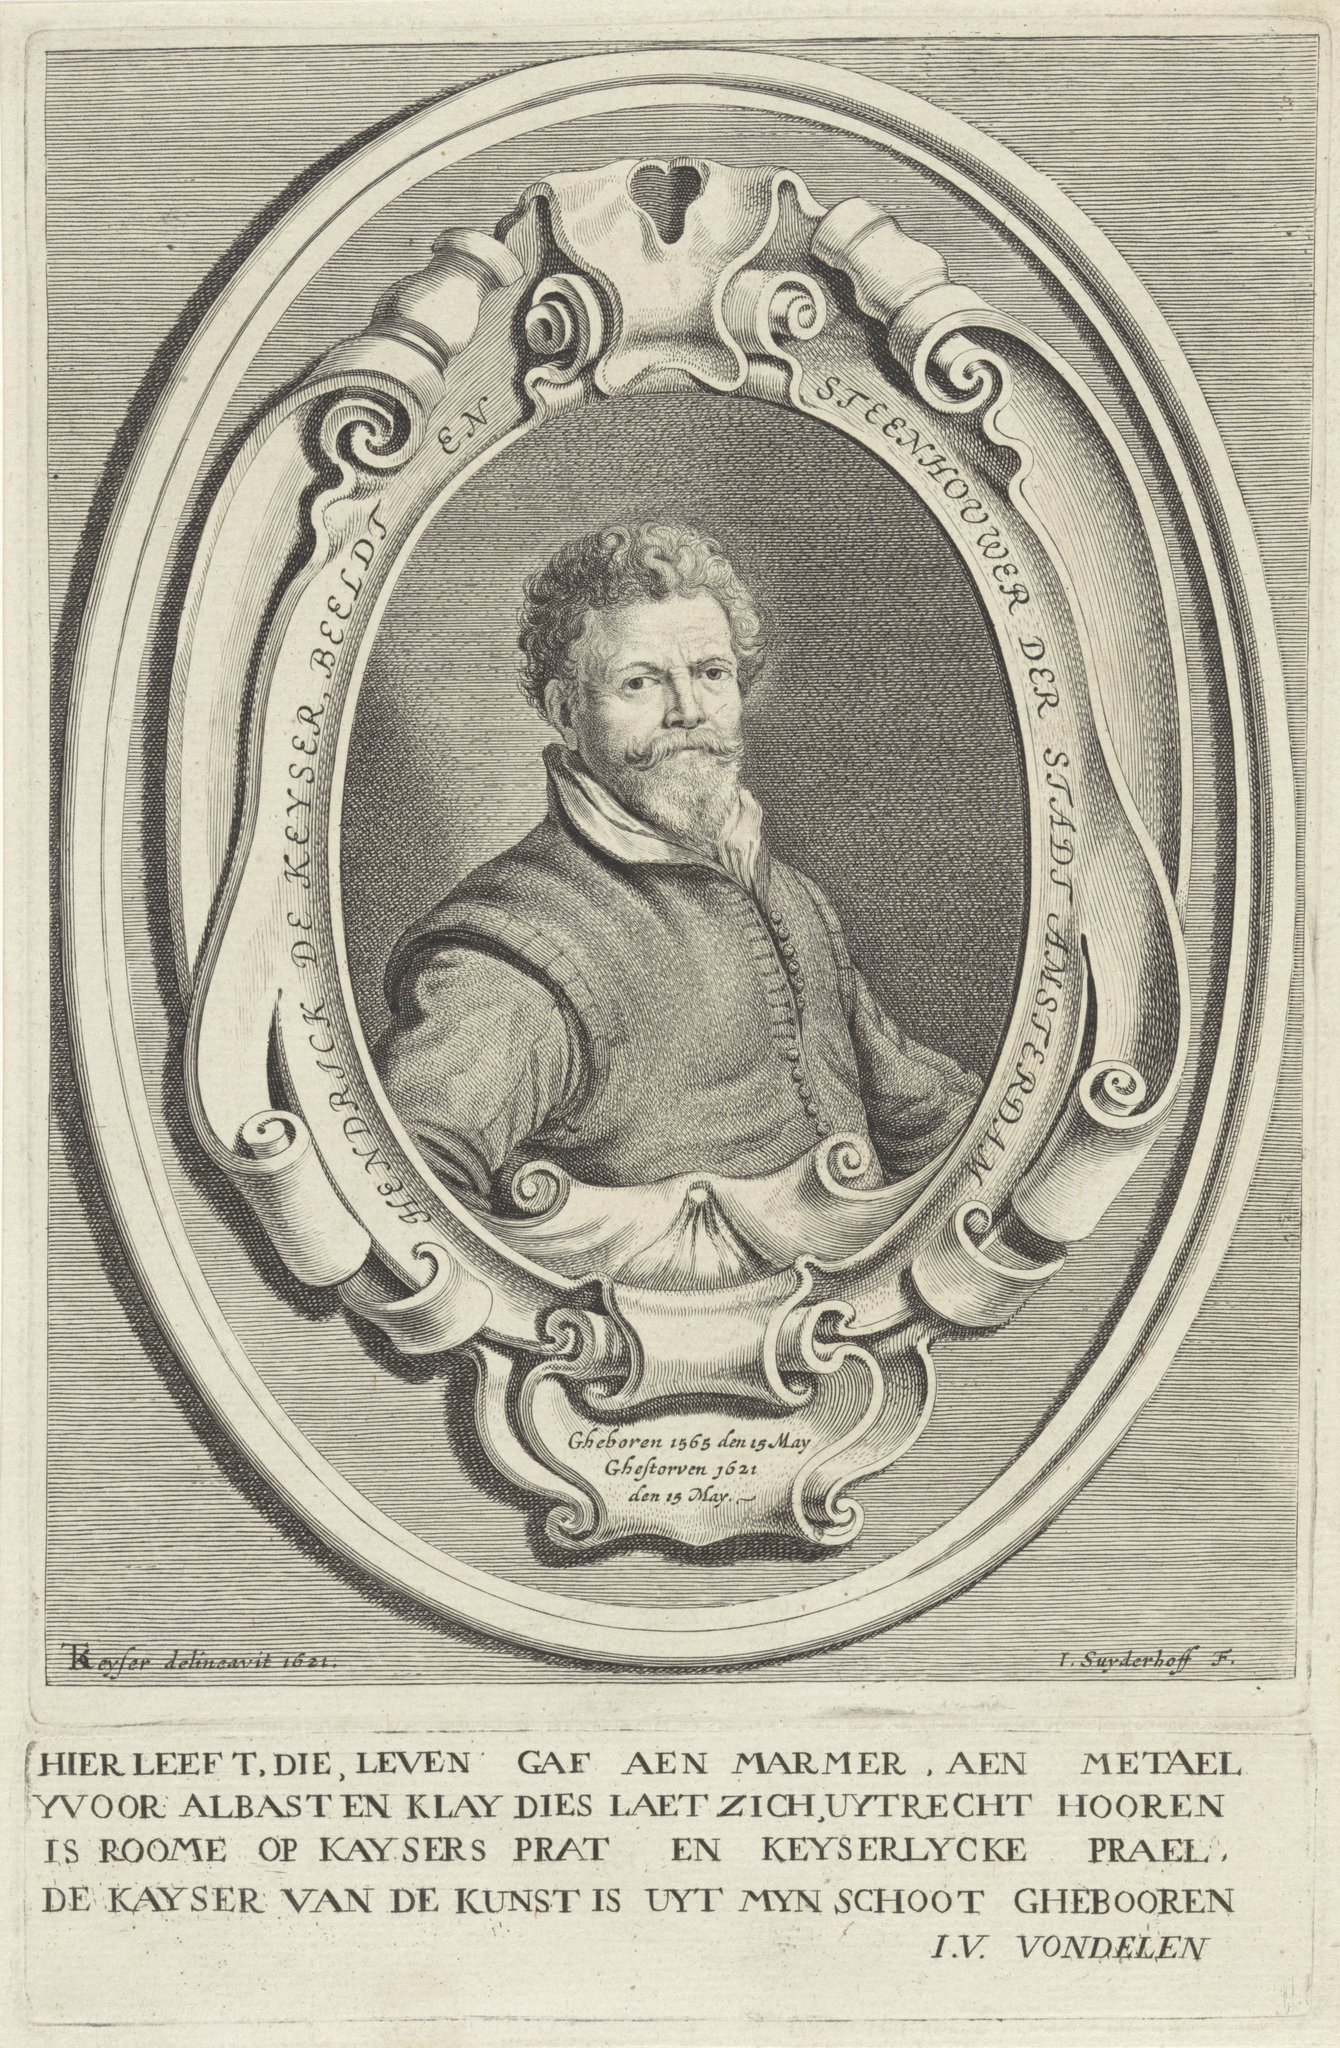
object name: print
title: Portret van Hendrik de Keyser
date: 1623-1686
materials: paper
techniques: engraving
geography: haarlem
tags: sculptor, hendrick de keyser (i), portrait, self-portrait of sculptor, portrait, self-portrait of architect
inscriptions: collector's mark: Lugt 2760, collector's mark: Lugt 2228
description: Portret van Hendrik de Keyser, architect en beeldhouwer te Amsterdam, in een ovale lijst met rolwerk.